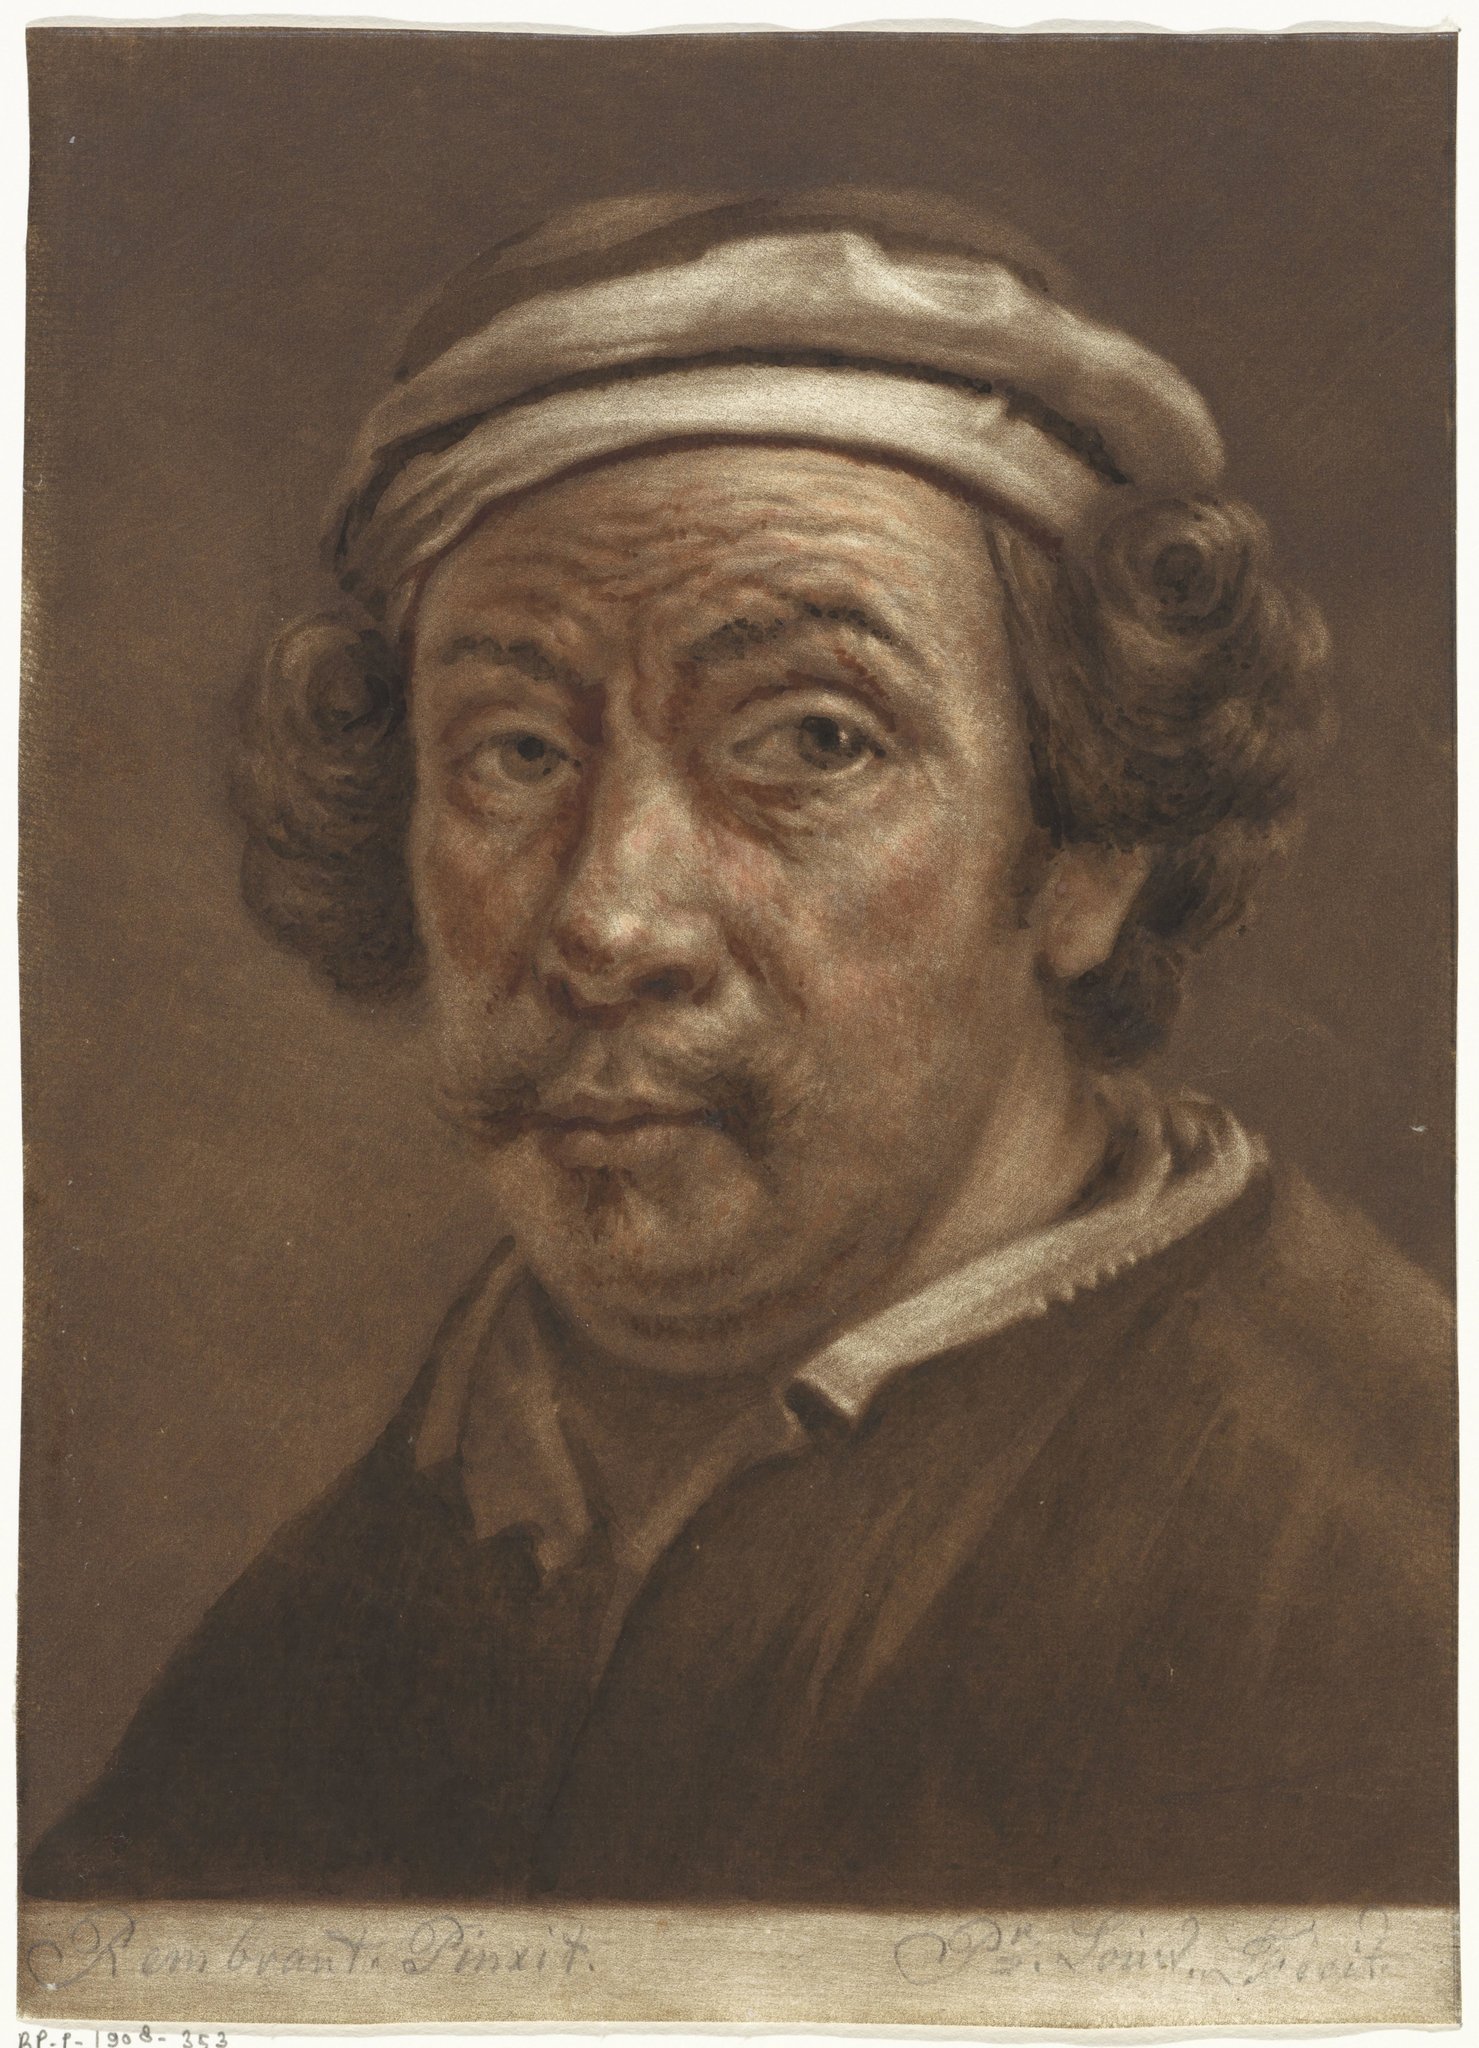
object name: print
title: Portret van Rembrandt van Rijn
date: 1743-1800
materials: paper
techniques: printing, hand coloring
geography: amsterdam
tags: leiden, painter, print maker, rembrandt van rijn, portrait, self-portrait of painter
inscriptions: collector's mark: Lugt 2228, inscription: ‘Rembrandt. Pinxit. P Louw. Fecit.’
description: Rembrandt van Rijn met een platte hoed op het hoofd.